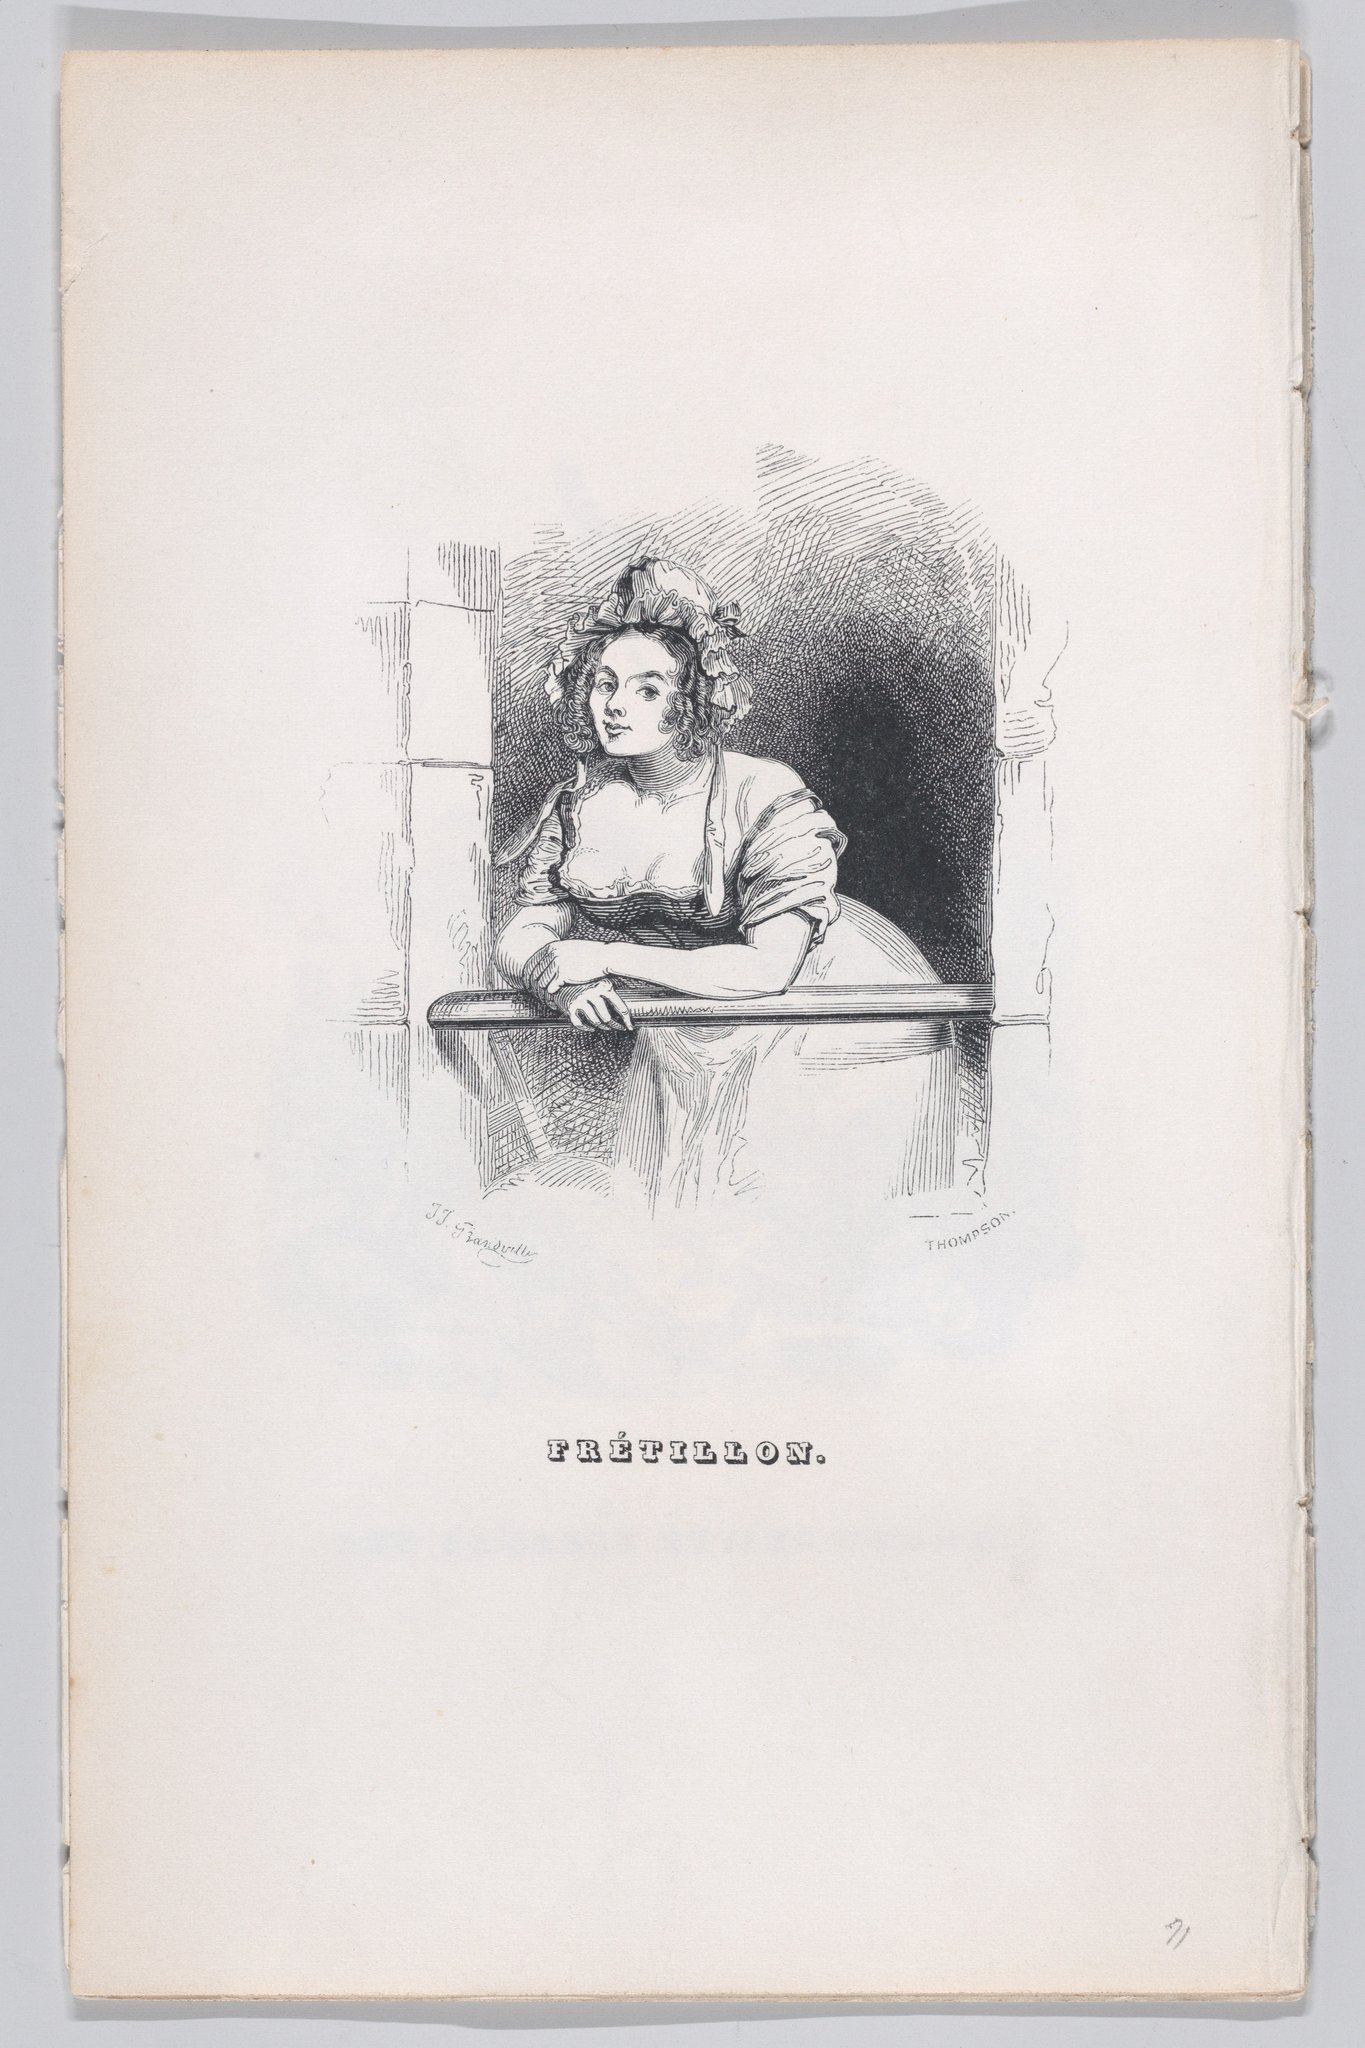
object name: print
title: Frétillon, from "The Complete Works of Béranger"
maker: j. j. grandville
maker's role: illustrator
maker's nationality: french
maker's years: 1803-1847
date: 1836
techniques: engraving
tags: women